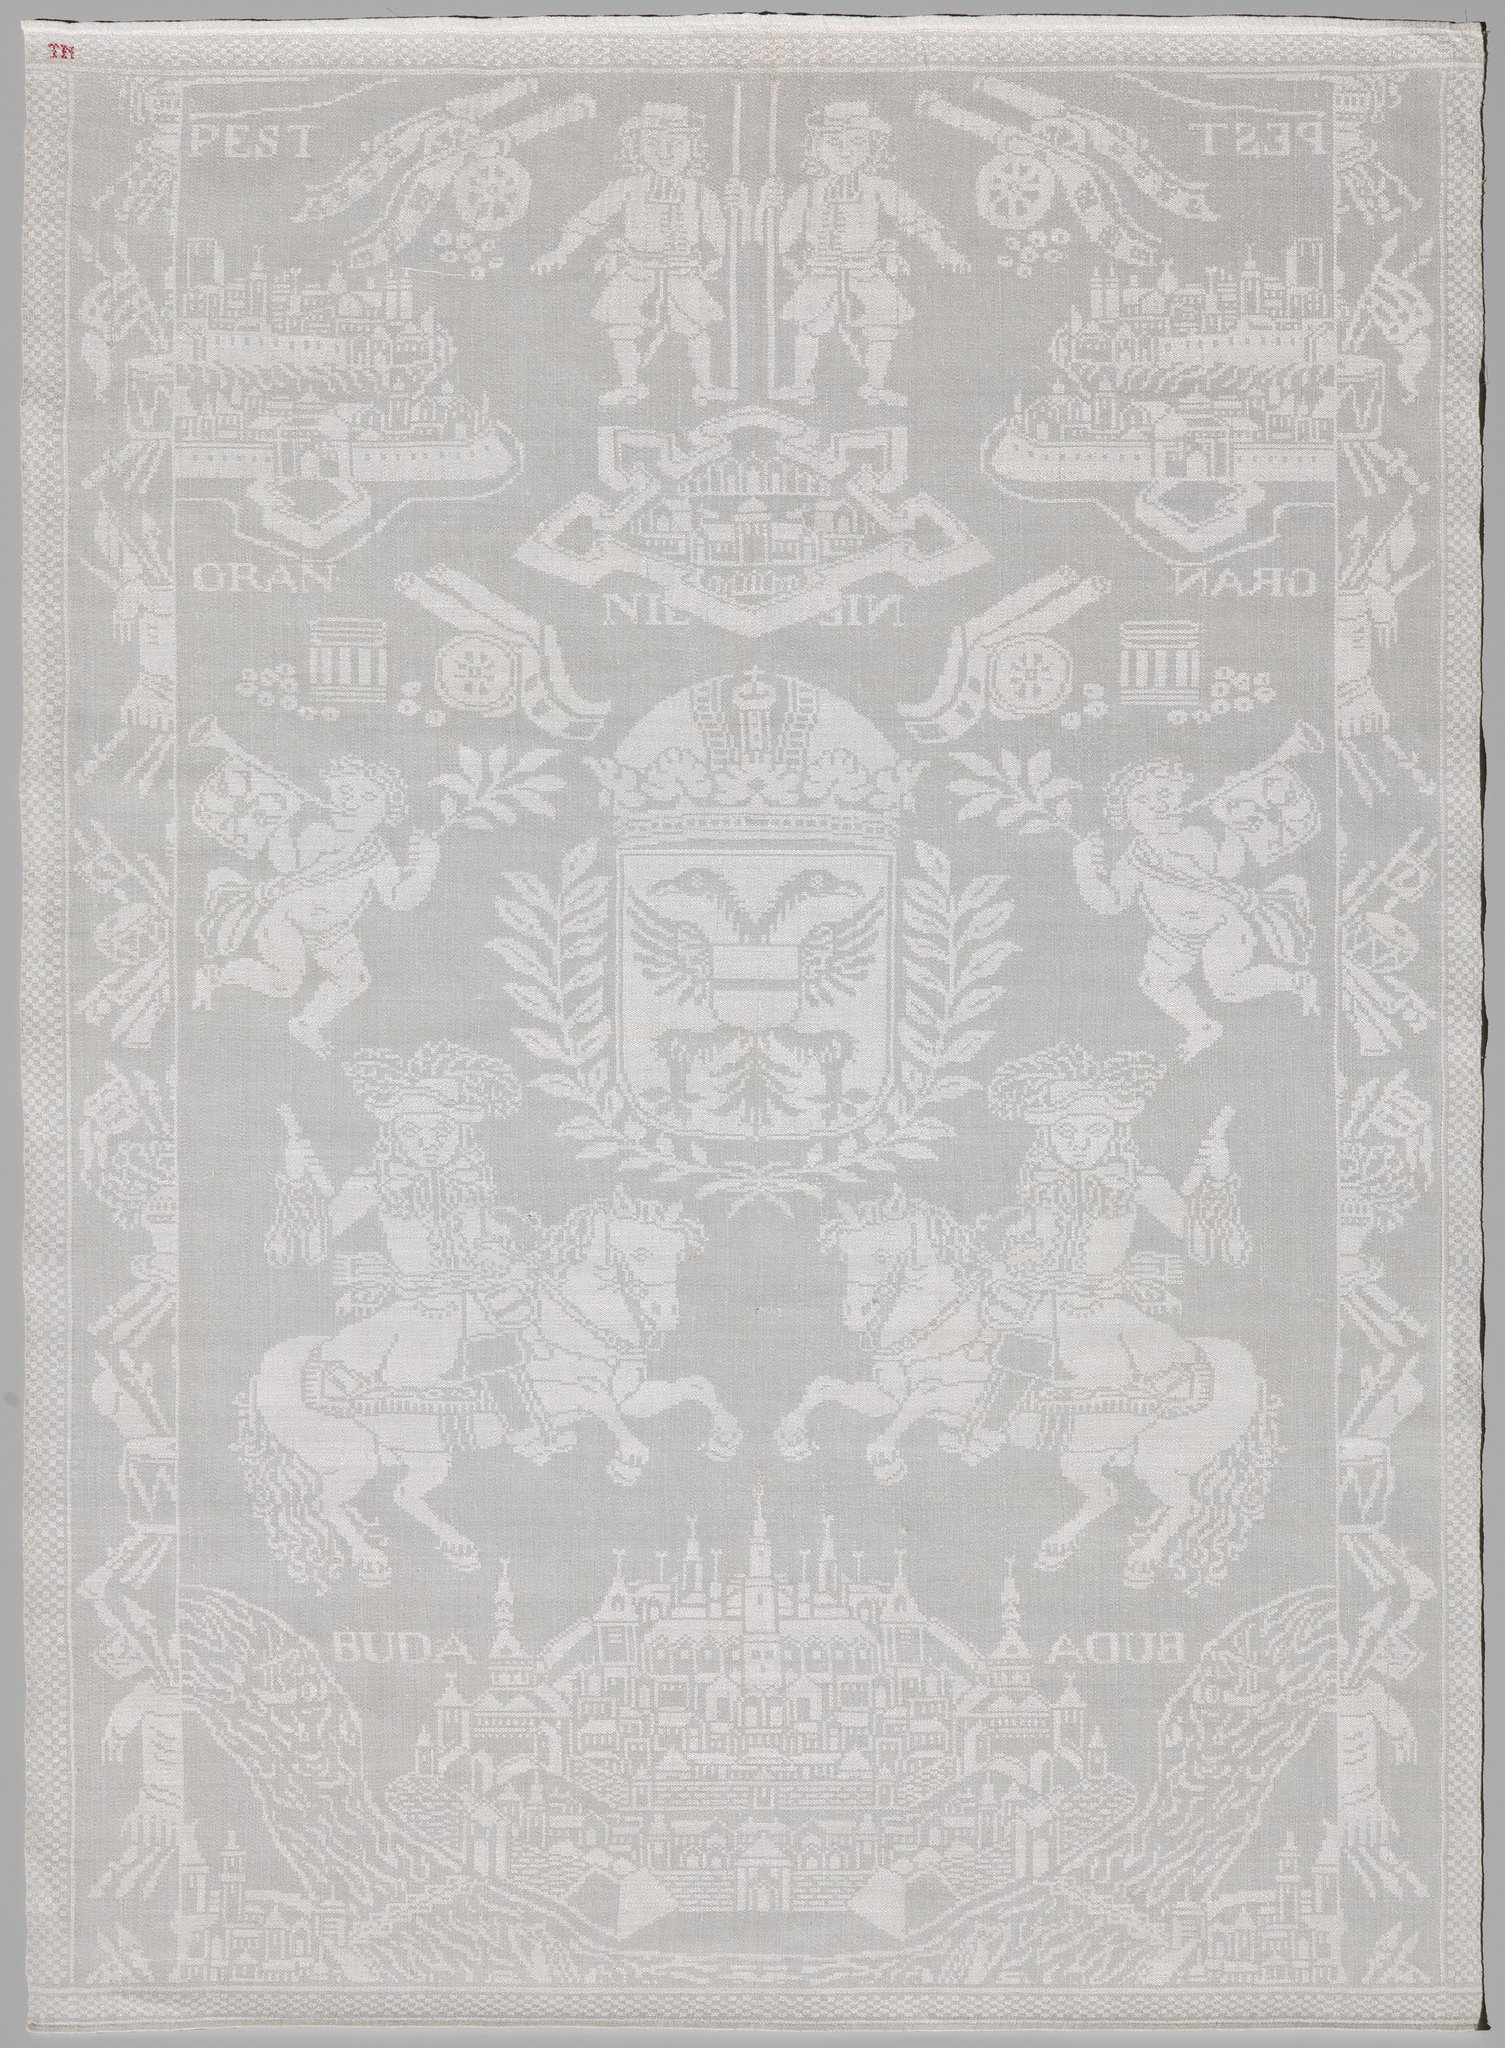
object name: napkin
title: Servet met de verovering van Neuhäusel, Gran, Buda en Pest door Leopold I, keizer van Duitsland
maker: Anonymous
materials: linen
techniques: damask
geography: flanders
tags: leopold i (keizer van duitsland)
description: Servet van linnendamast met de verovering van Neuhäusel, Gran, Buda en Pest door Leopold I; met het wapen van het Heilige Roomse Rijk met hartschild Oosterijk.